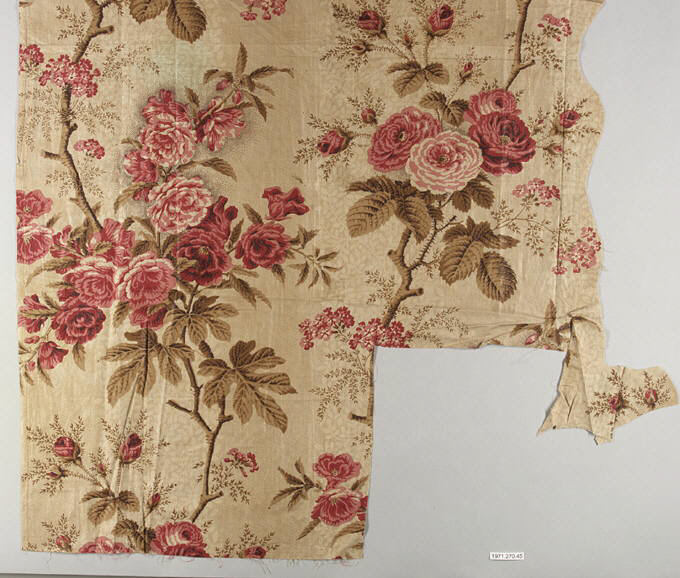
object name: picture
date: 1830-1840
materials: cotton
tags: flowers,leaves